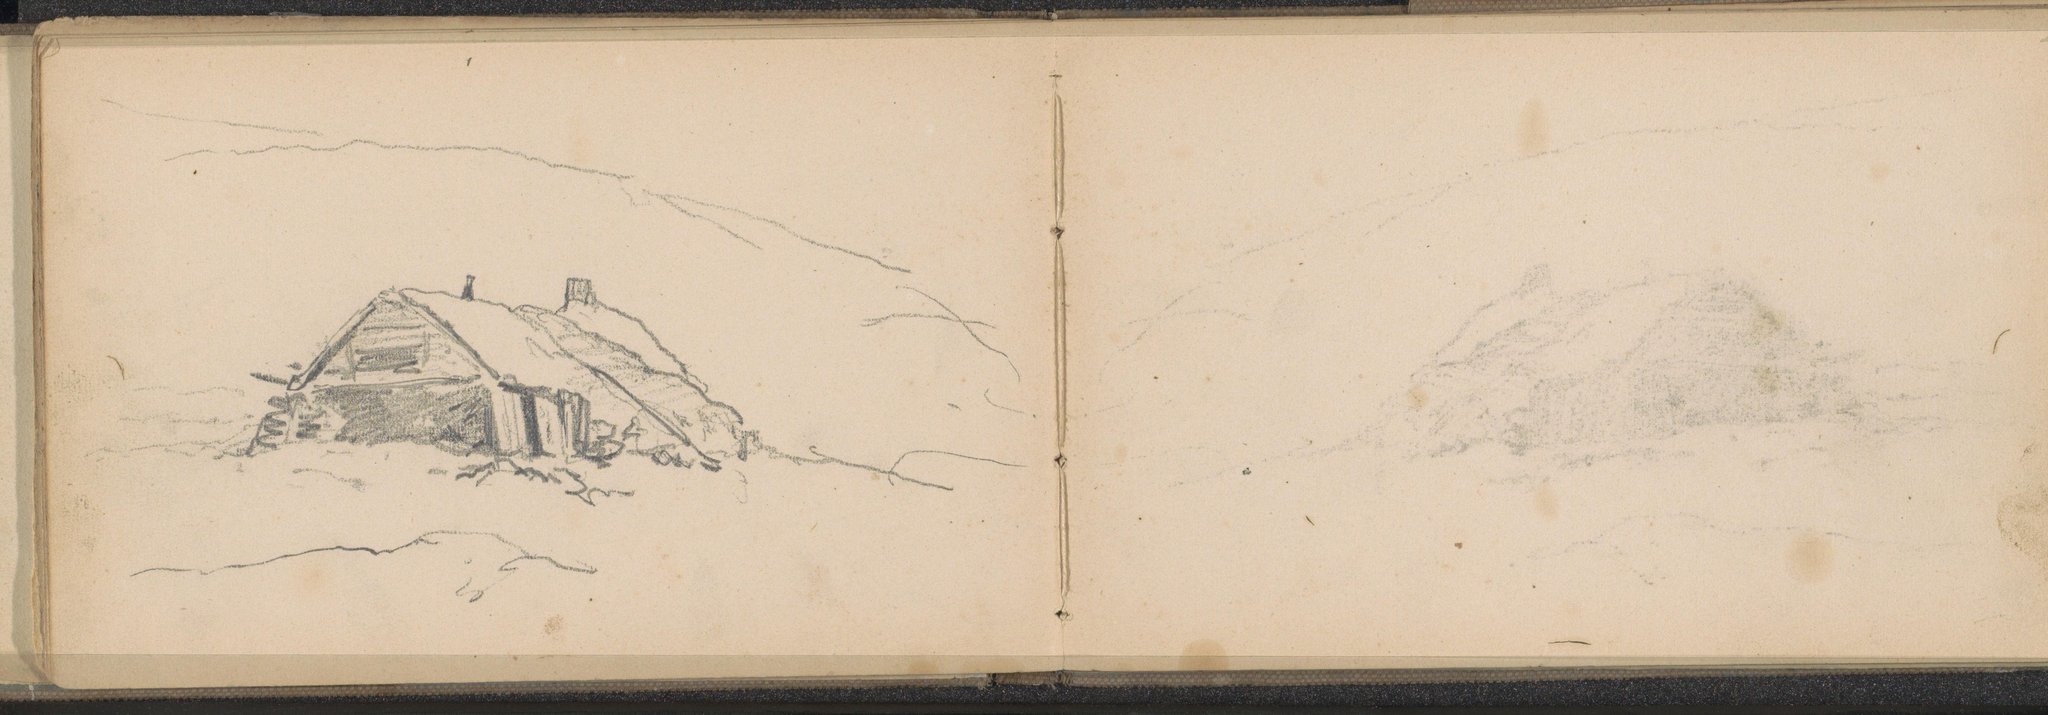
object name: sketchbook leaf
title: Gezicht op een huis in Noors Sápmi (Lapland)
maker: louis apol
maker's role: draughtsman, painter, print maker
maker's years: 1850-1936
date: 1809-1880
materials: paper, pencil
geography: norway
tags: landscapes, europeans: sami, civic architecture; edifices; dwellings, sápmi, norway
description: Blad 14 verso uit een schetsboek met 38 bladen betekend tijdens de expeditie naar Nova Zembla in 1880.